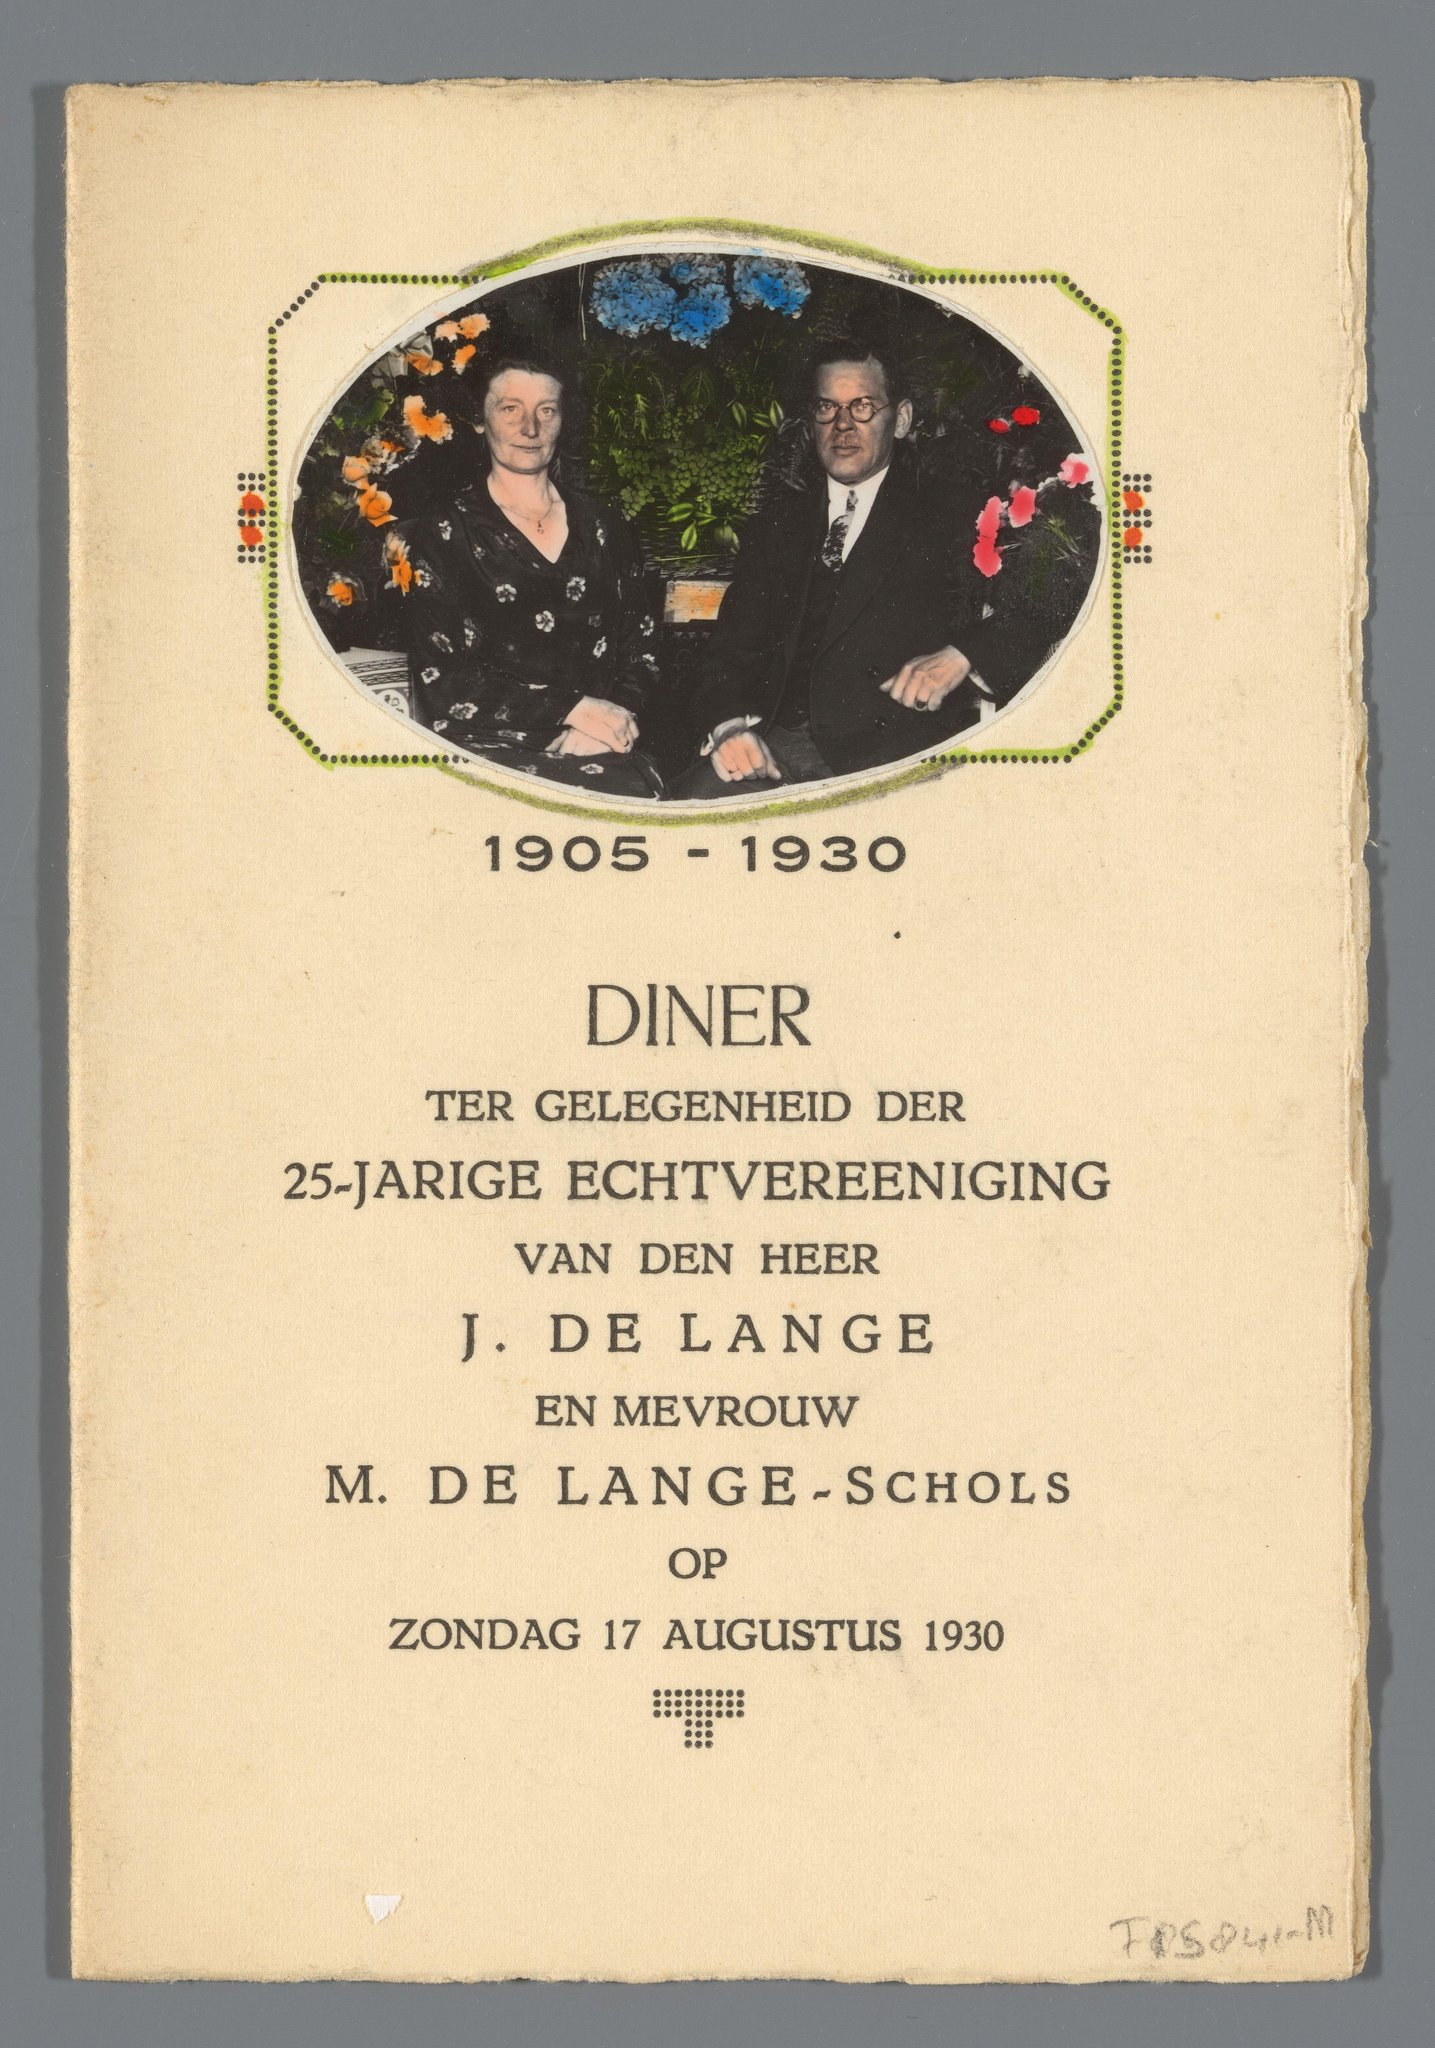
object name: menu, menukaart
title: Menukaart voor een diner ter ere van het 25-jarig huwelijk van J. de Lange en M. de Lange-Schols, met portret van het echtpaar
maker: Anonymous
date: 1930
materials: paper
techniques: gelatin silver print, hand coloring, letterpress printing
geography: netherlands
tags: historical persons, couple of lovers, netherlands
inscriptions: inscription: ‘1905-1930/ Diner/ ter gelegenheid der/ 25-jarige echtvereeniging/ van den heer/ J. de Lange/ en mevrouw/ M. de Lange-Schols/ op/ 17 augustus 1930’, inscription